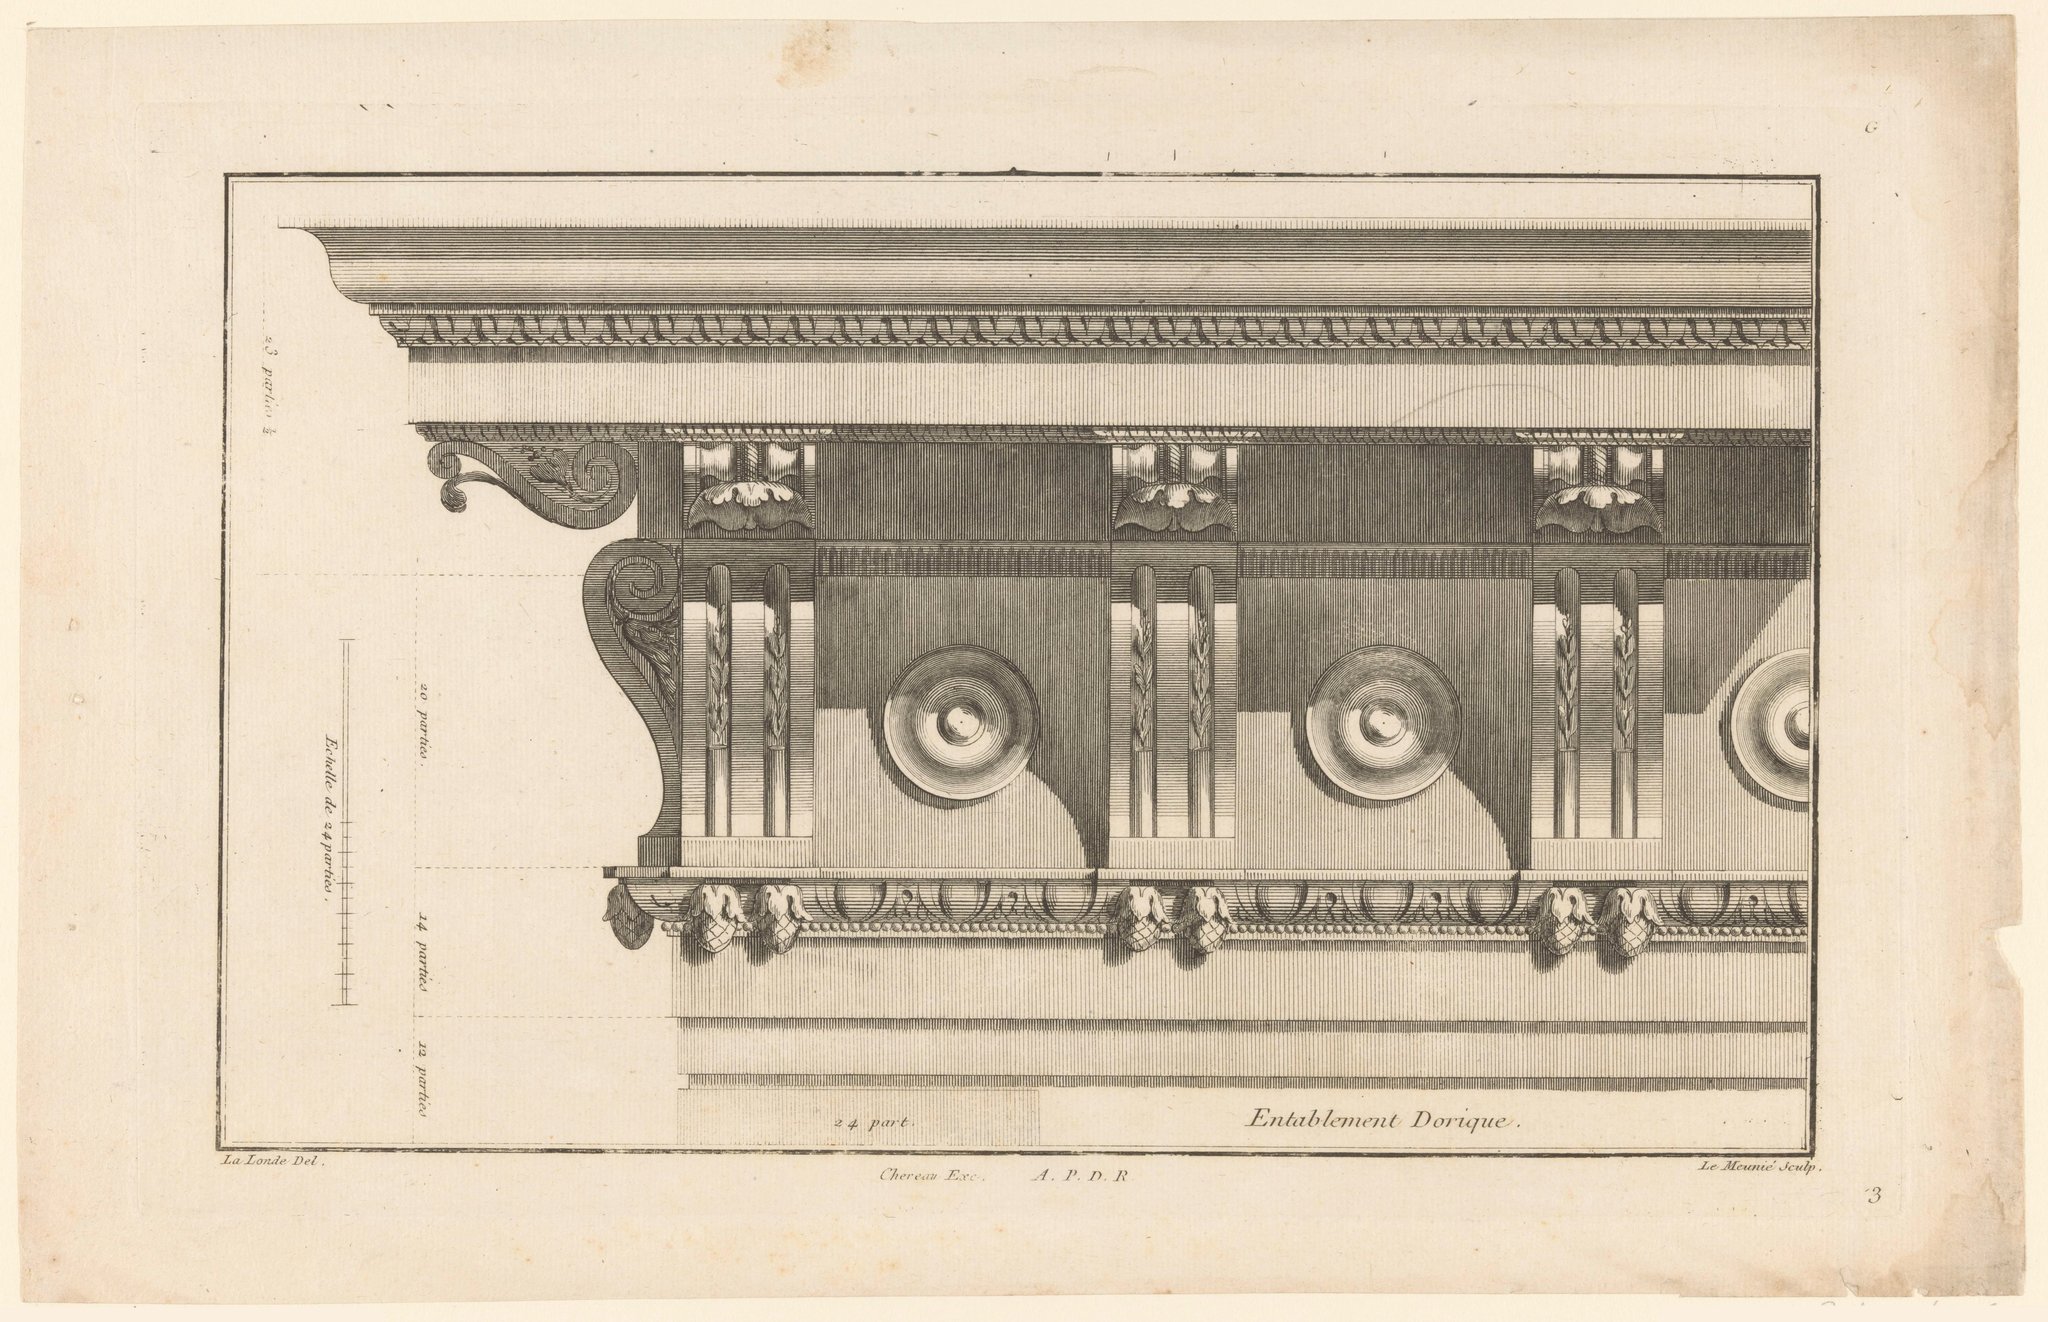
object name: print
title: Entablement Dorique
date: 1784-1785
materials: paper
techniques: engraving, etching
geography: paris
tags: doric order ~ architecture, other architectural details (entablature)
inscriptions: collector's mark: Lugt 2228, collector's mark: Lugt 2760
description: Een Dorisch hoofdgestel met ronde elementen, een eierlijst en dennenappels.